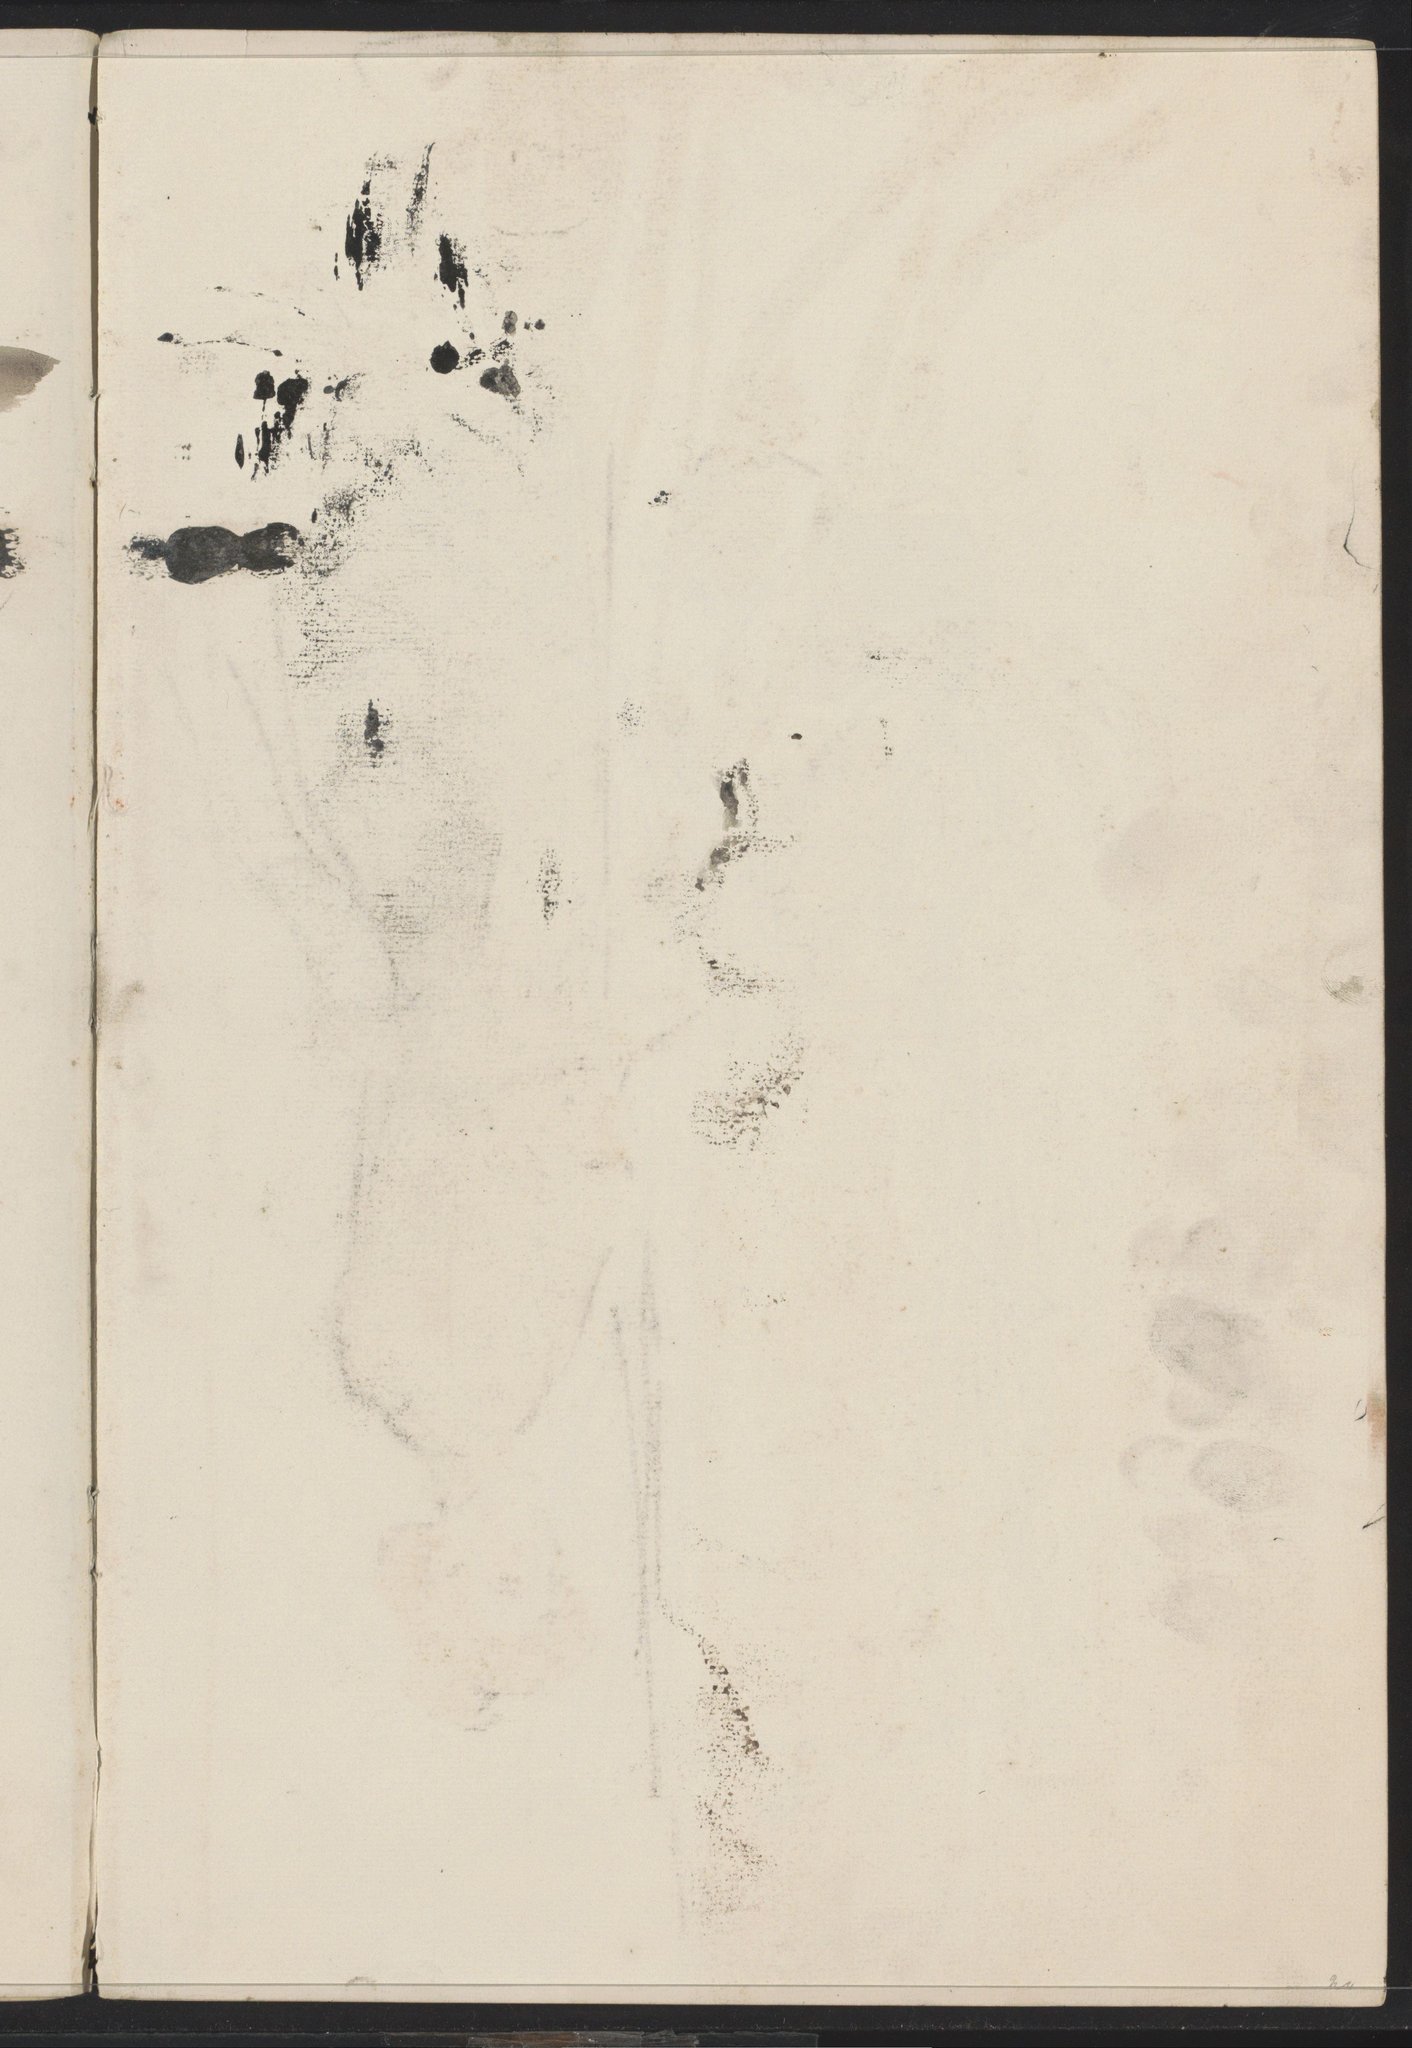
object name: sketchbook leaf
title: Abklatsch van de tekening op blad 19 verso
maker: isaac israels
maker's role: draughtsman, painter, print maker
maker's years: 1865-1934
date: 1875-1934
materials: paper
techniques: printmaking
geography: the hague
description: Blad 20 recto uit schetsboek LXIX met 25 bladen.